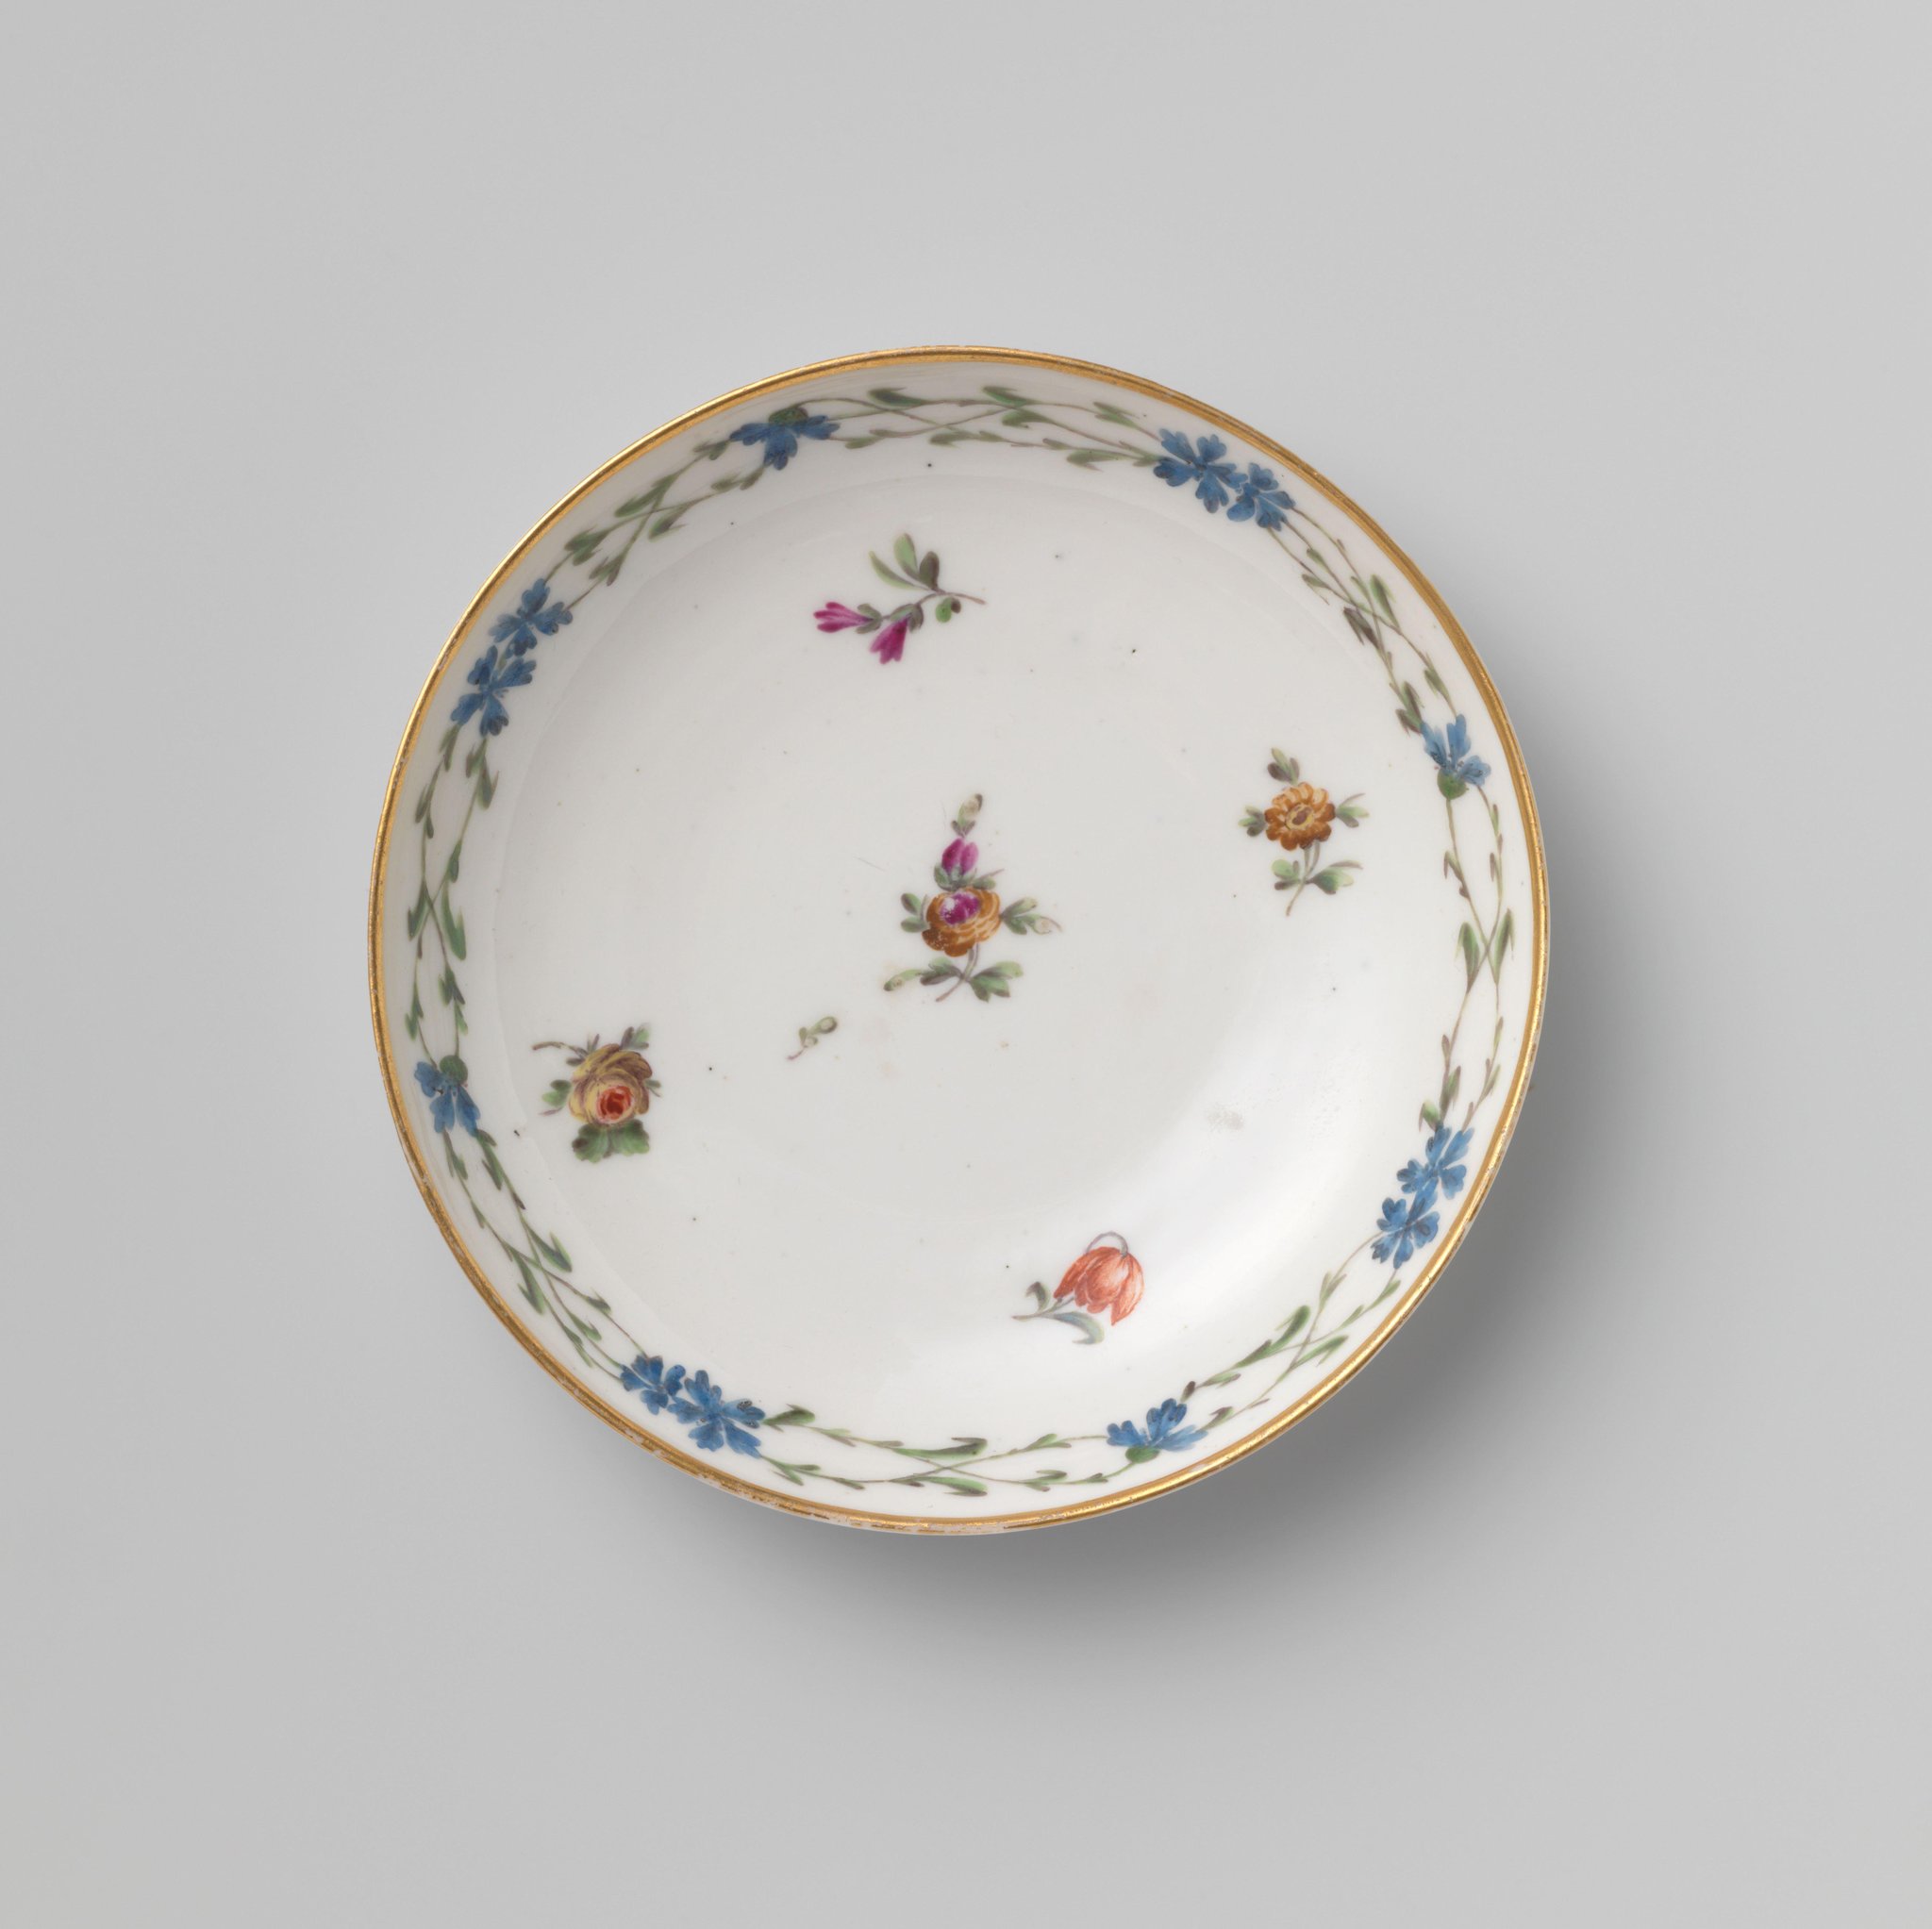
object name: platter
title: Schotel van porselein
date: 1774-1784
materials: porcelain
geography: loosdrecht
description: Beschilderd met een rand met korenbloemen en losse bloemtakken.